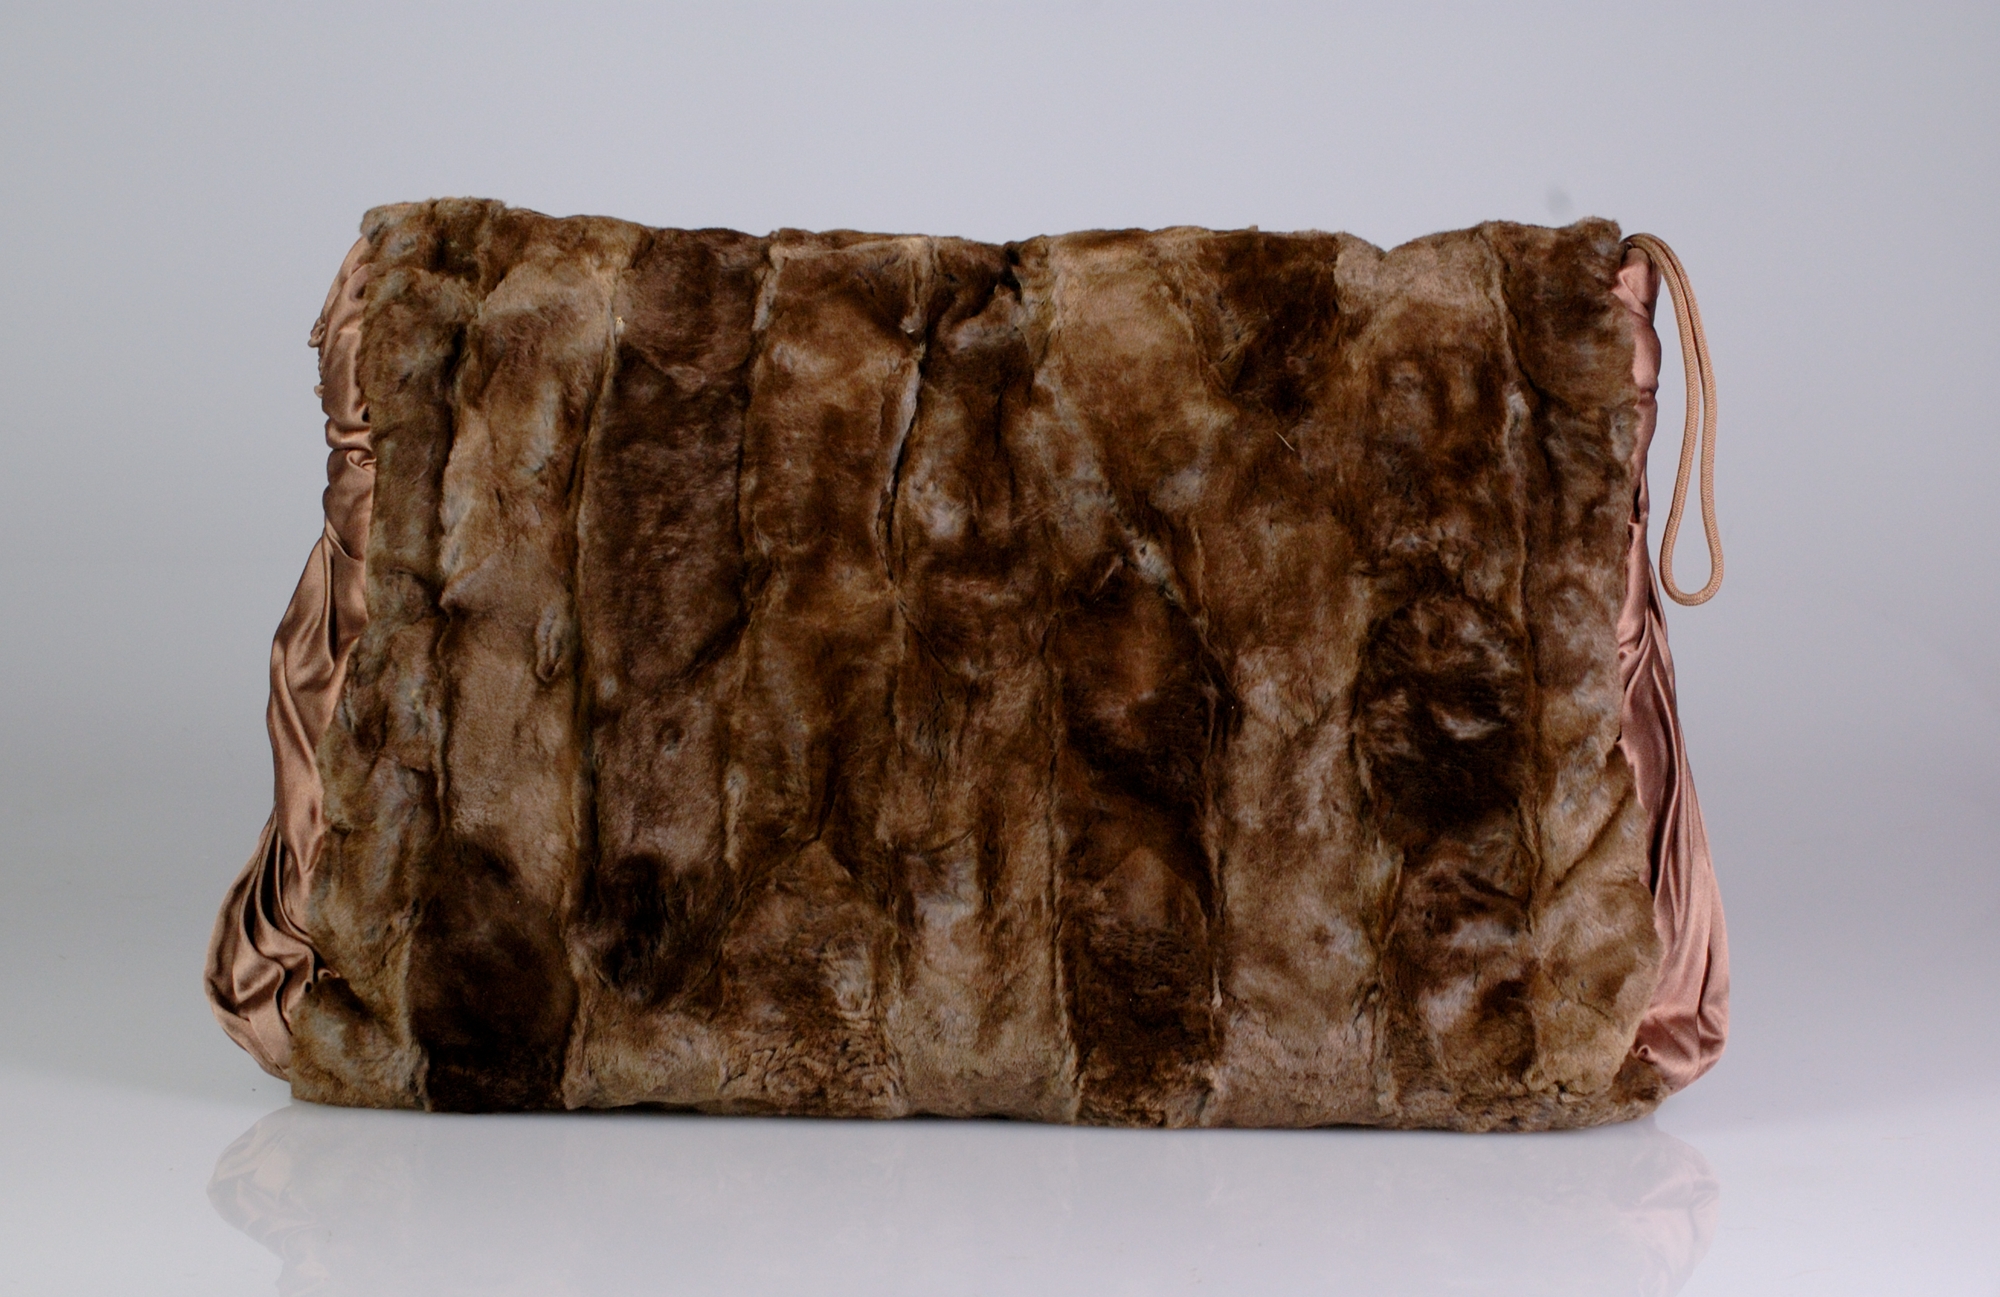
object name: muff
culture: american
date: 1885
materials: fur, silk